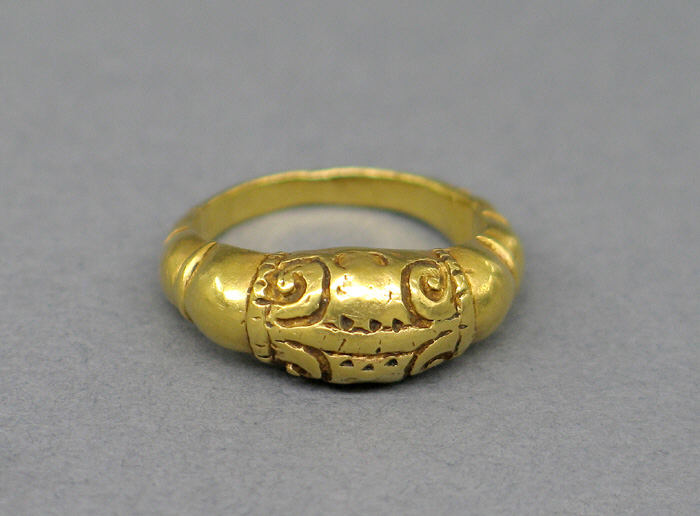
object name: ring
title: Ring with Ribbed Hoop and Incised Floral Motif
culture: indonesian, javanese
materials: gold